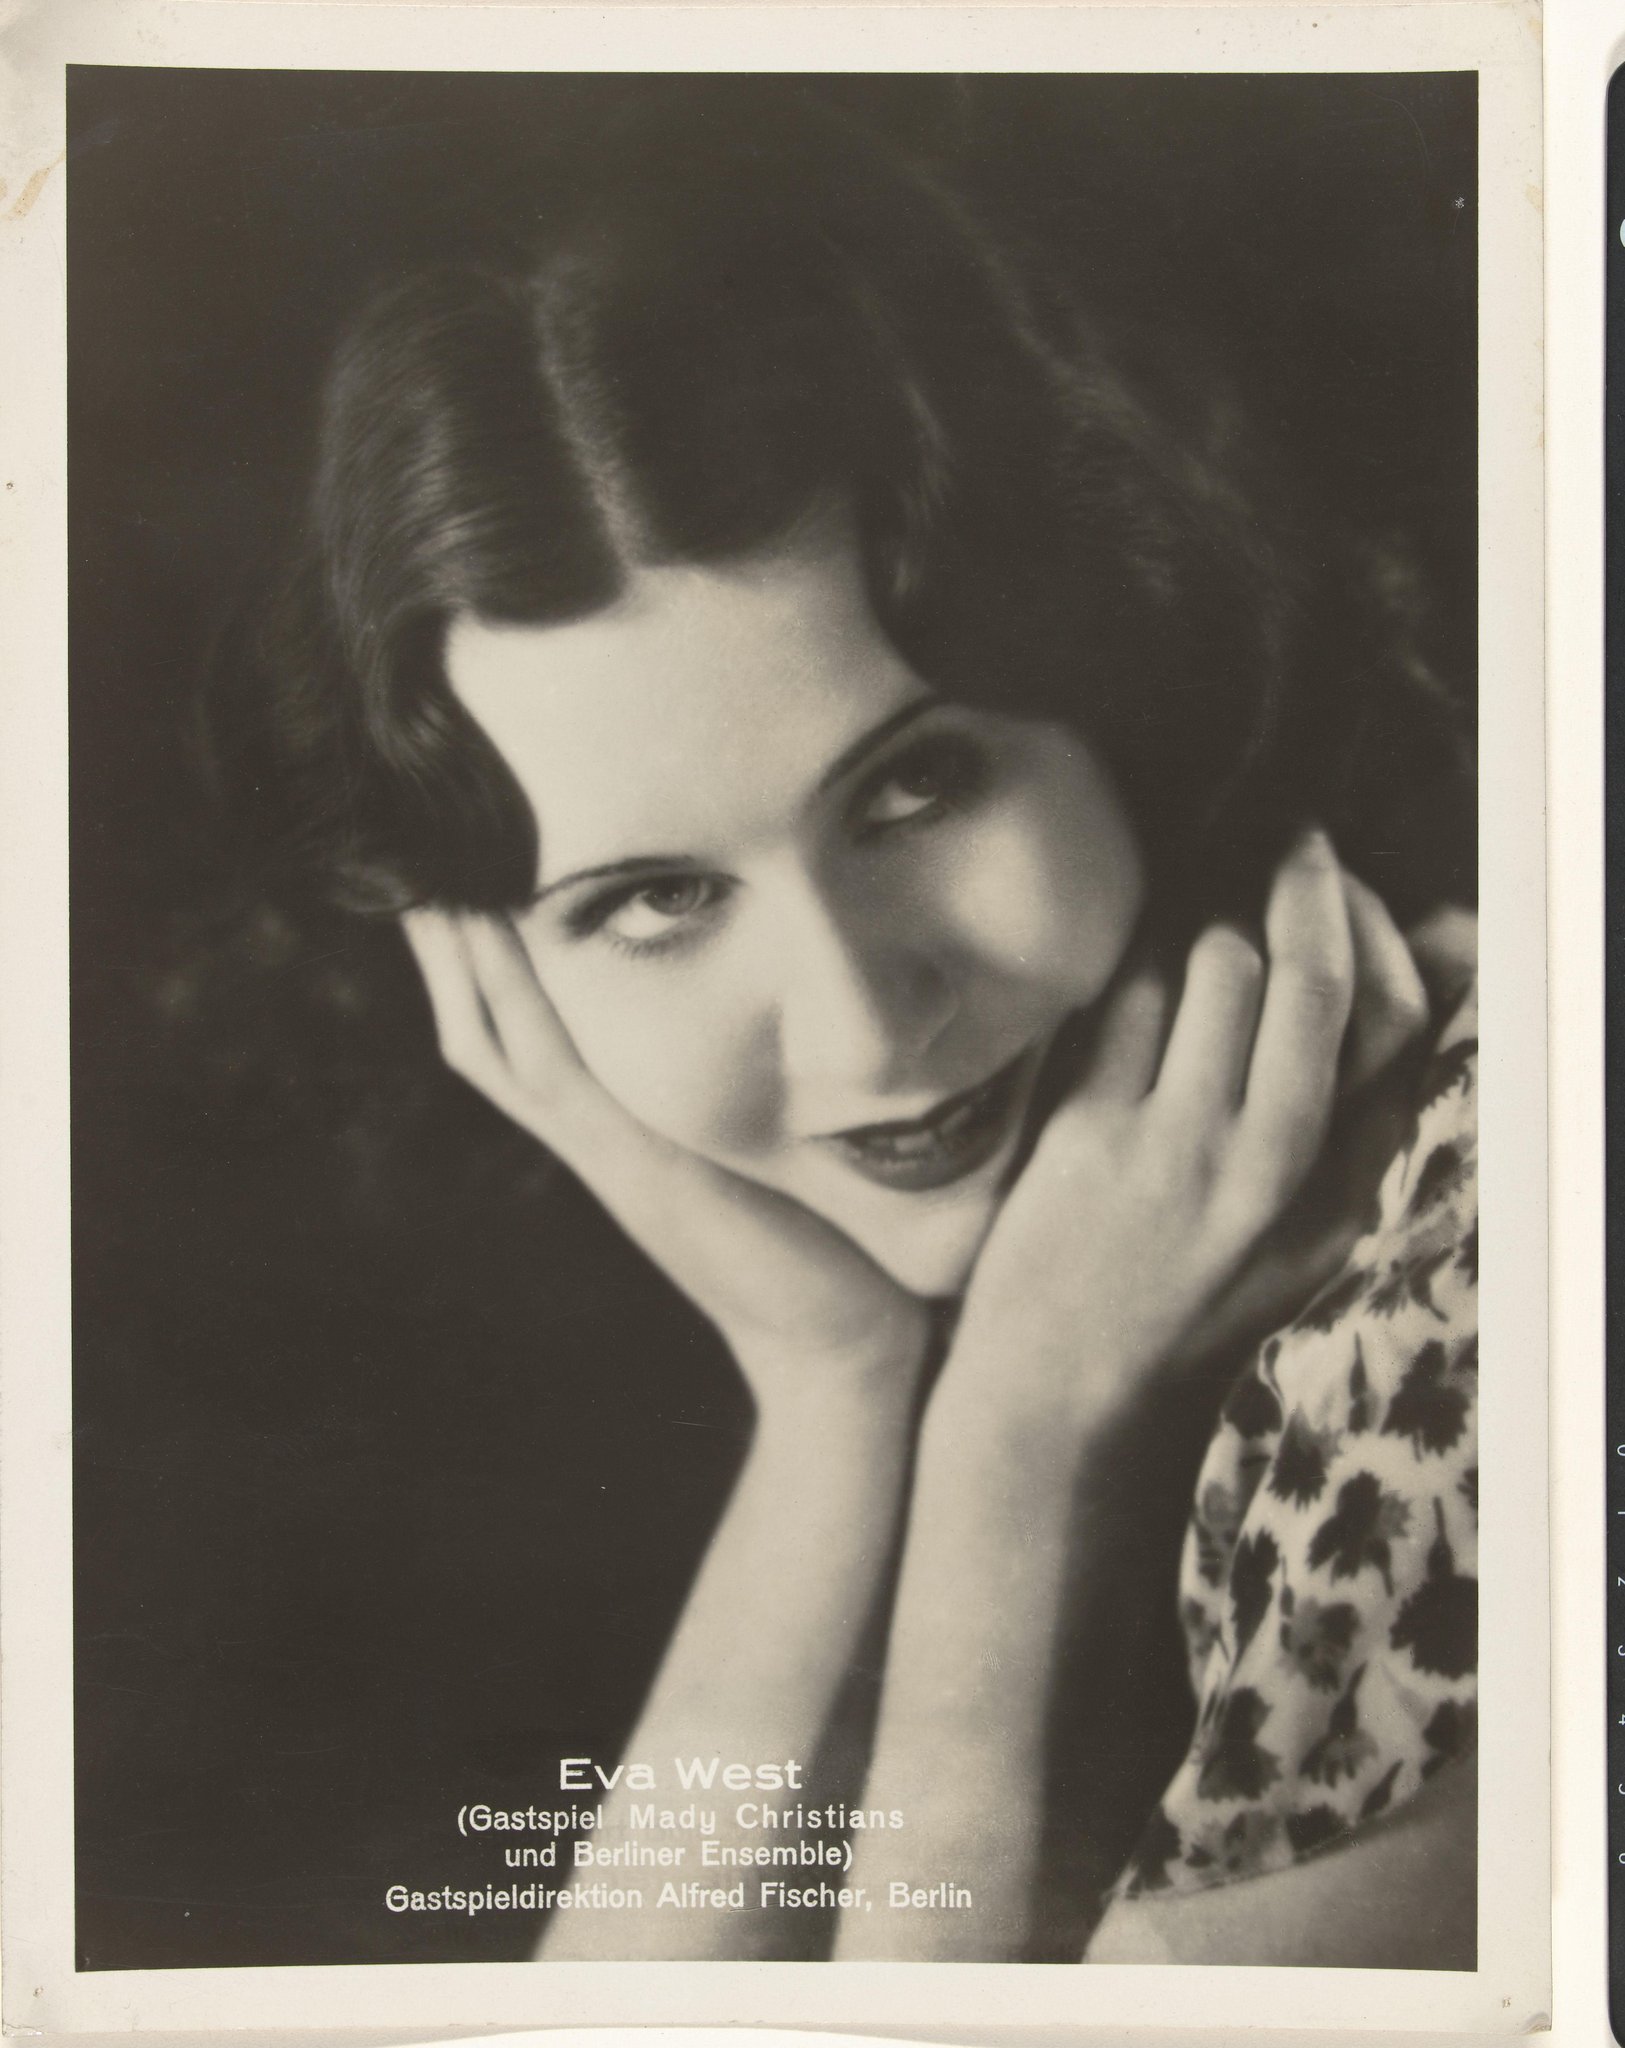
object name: photograph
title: Portret van een Duitse actrice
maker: Anonymous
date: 1900-1985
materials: photographic support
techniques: gelatin silver print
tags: germany